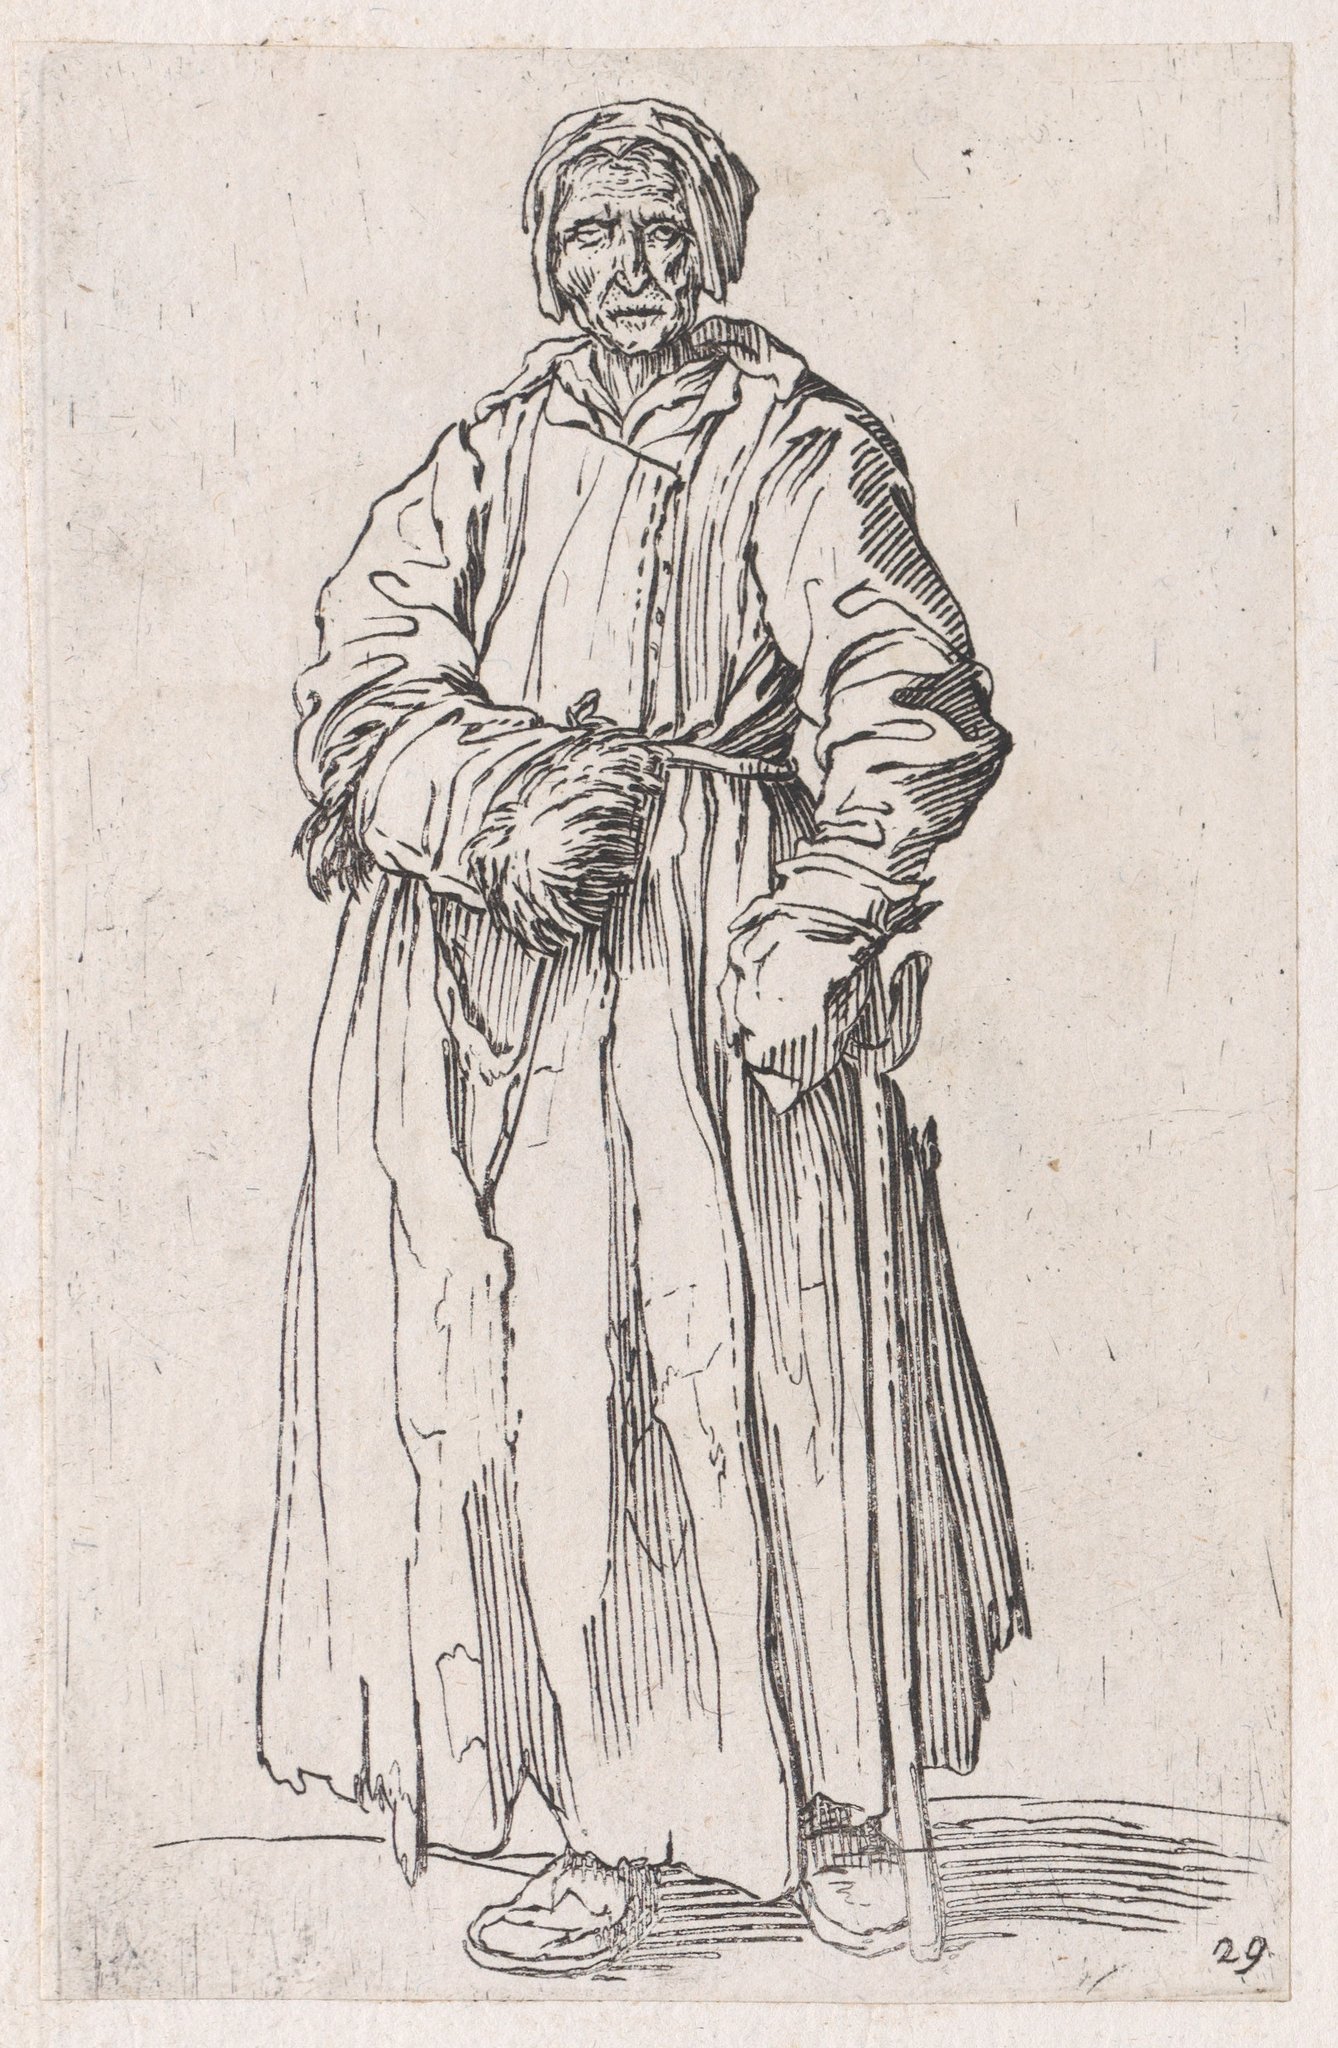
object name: print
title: Reverse Copy of Le Mendiant aux Béquilles Coiffée d'un Chapeau et Vu de Dos (The Beggar with Crutches Wearing a Hat and Viewed from Behind), from Les Gueux suite appelée aussi Les Mendiants, Les Baroni, ou Les Barons (The Beggars, also called the Barons)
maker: Anonymous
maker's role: artist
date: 1601-1700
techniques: etching